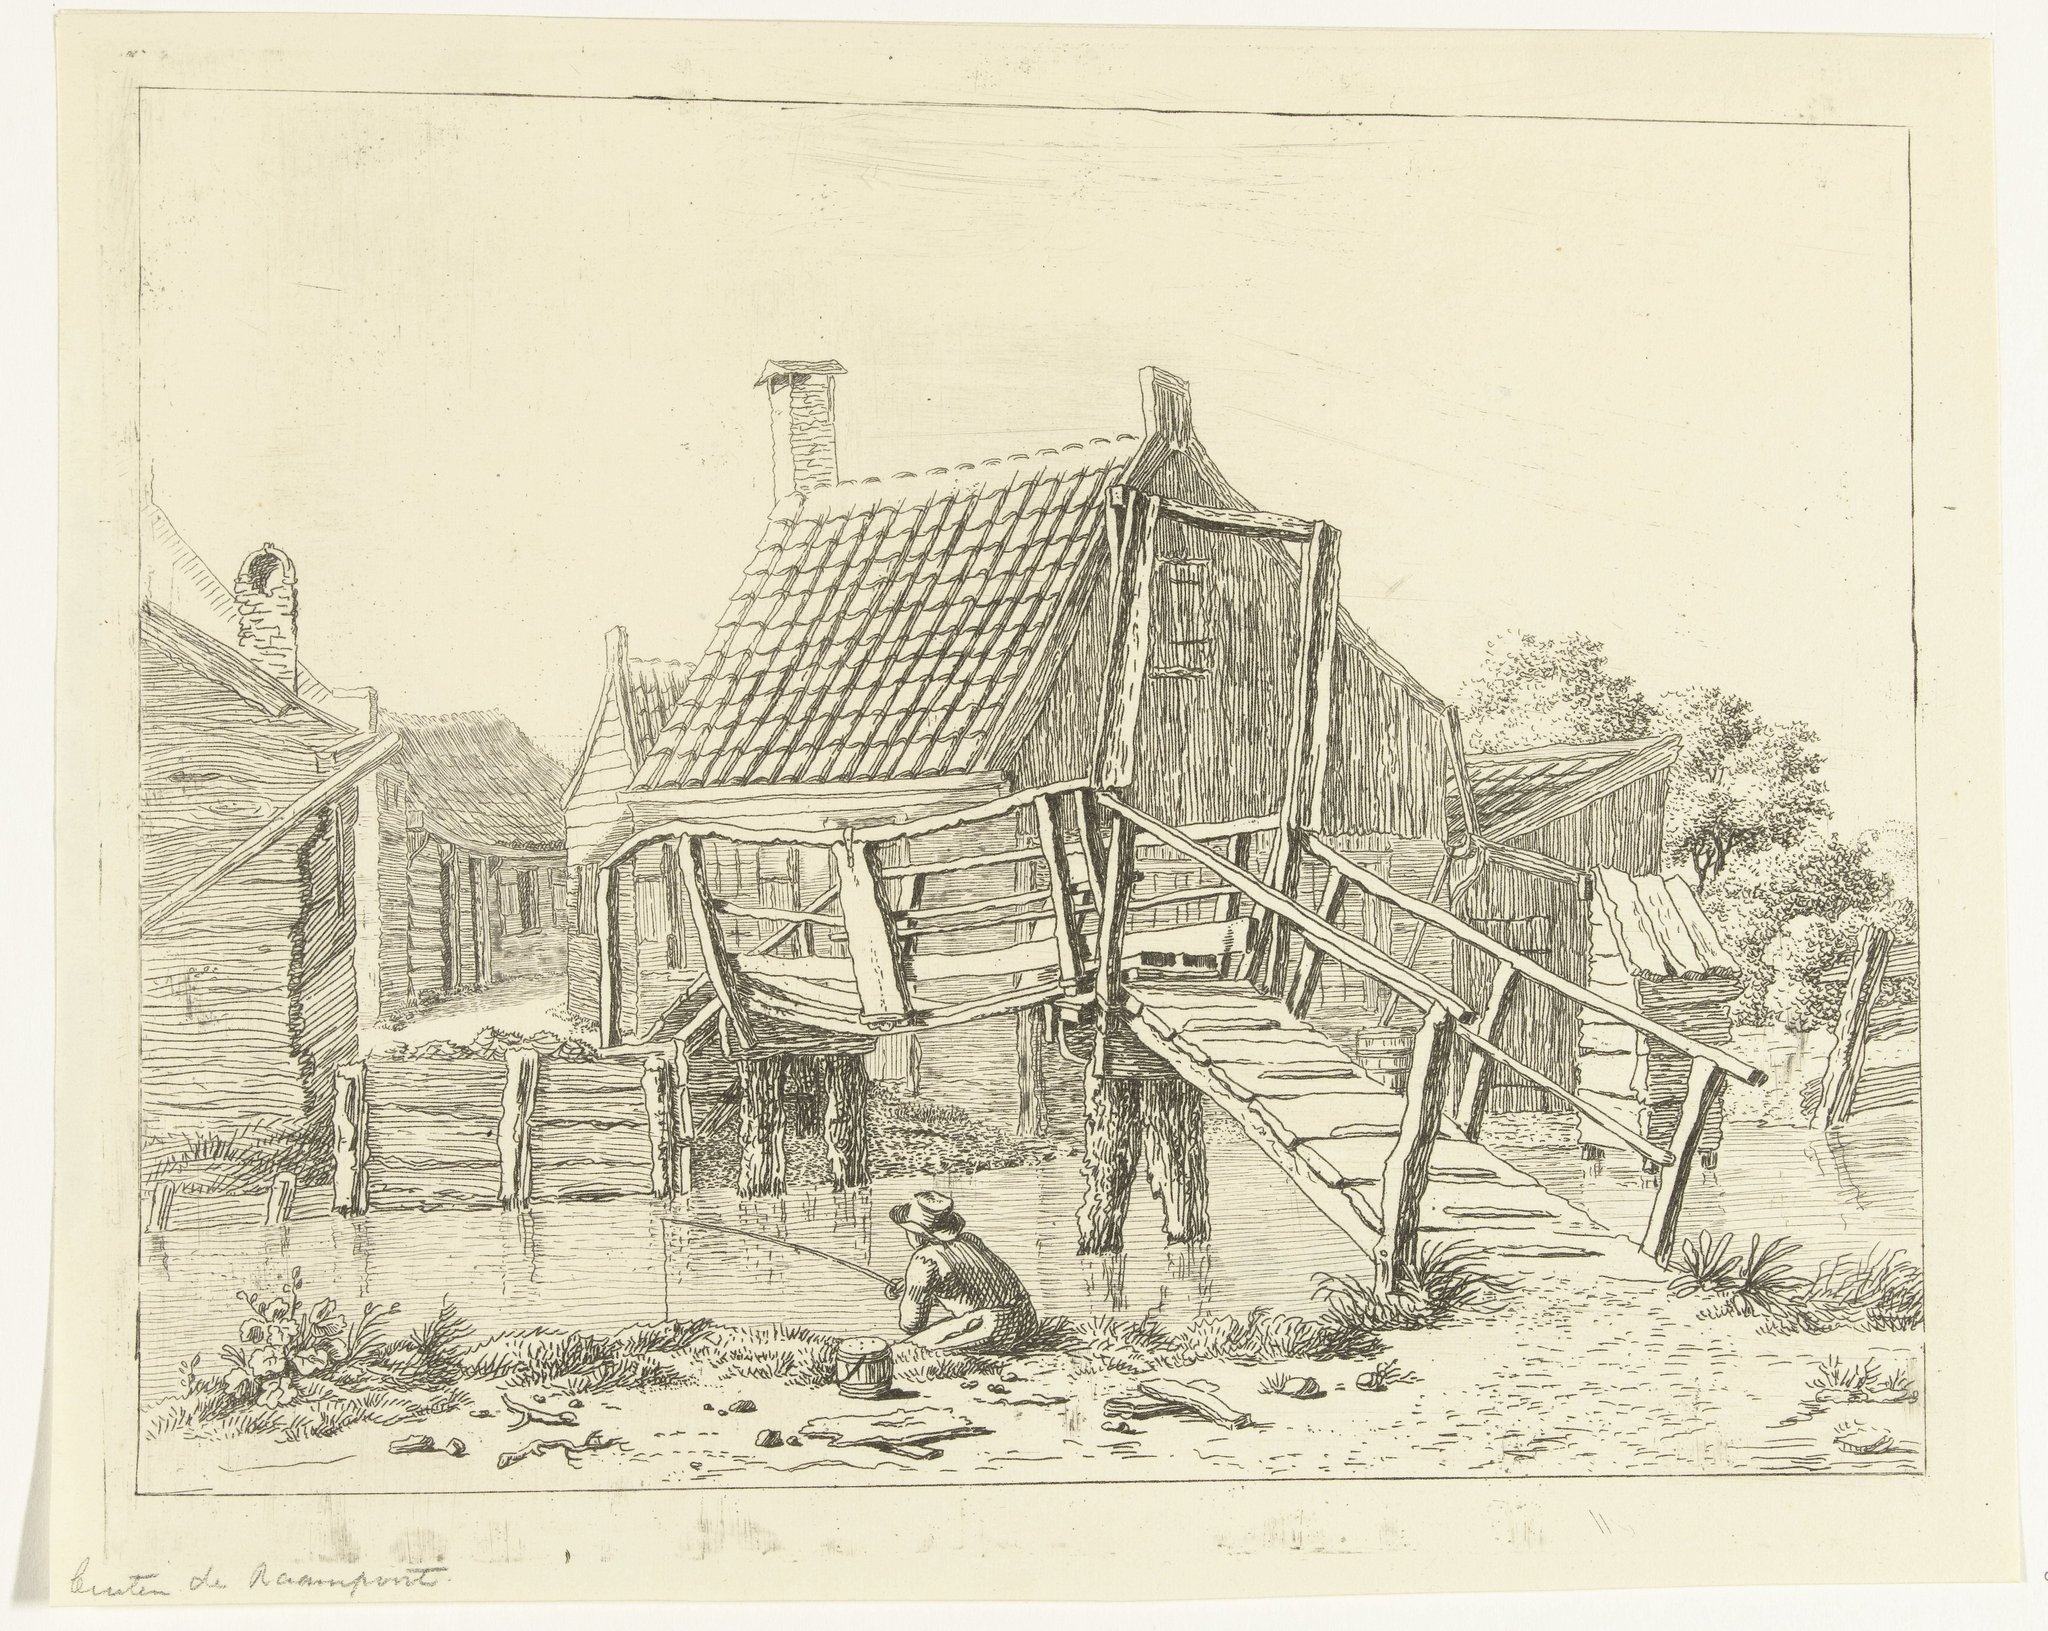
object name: print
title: Buiten de Raampoort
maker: anthonie van den bos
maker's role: draughtsman, print maker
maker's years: 1763-1838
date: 1778-1838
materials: paper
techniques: printmaking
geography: netherlands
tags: angling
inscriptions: collector's mark: Lugt 2228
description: Een man zit aan de oever van een sloot te hengelen vlakbij een houten brug.